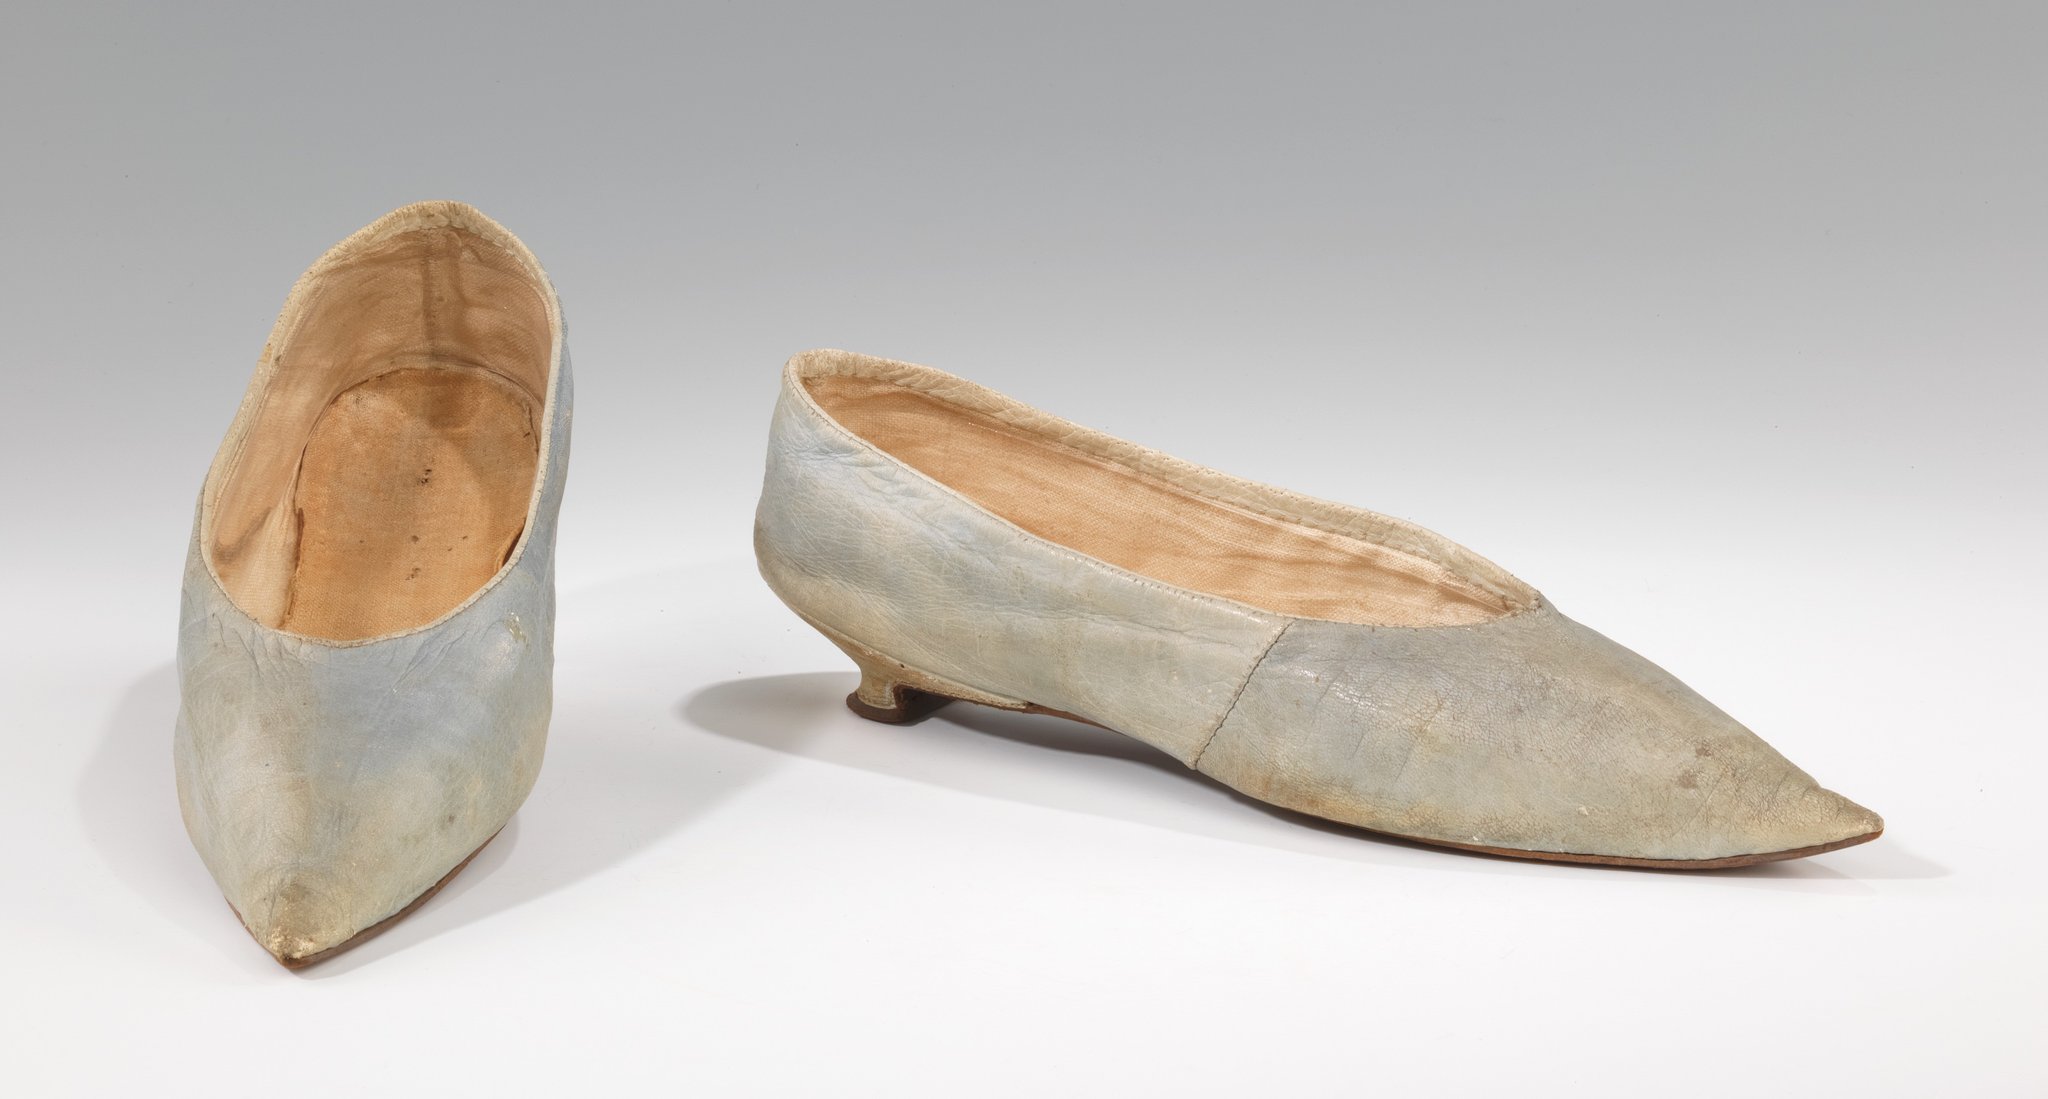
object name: slipper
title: Slippers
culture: british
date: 1795-1810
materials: leather